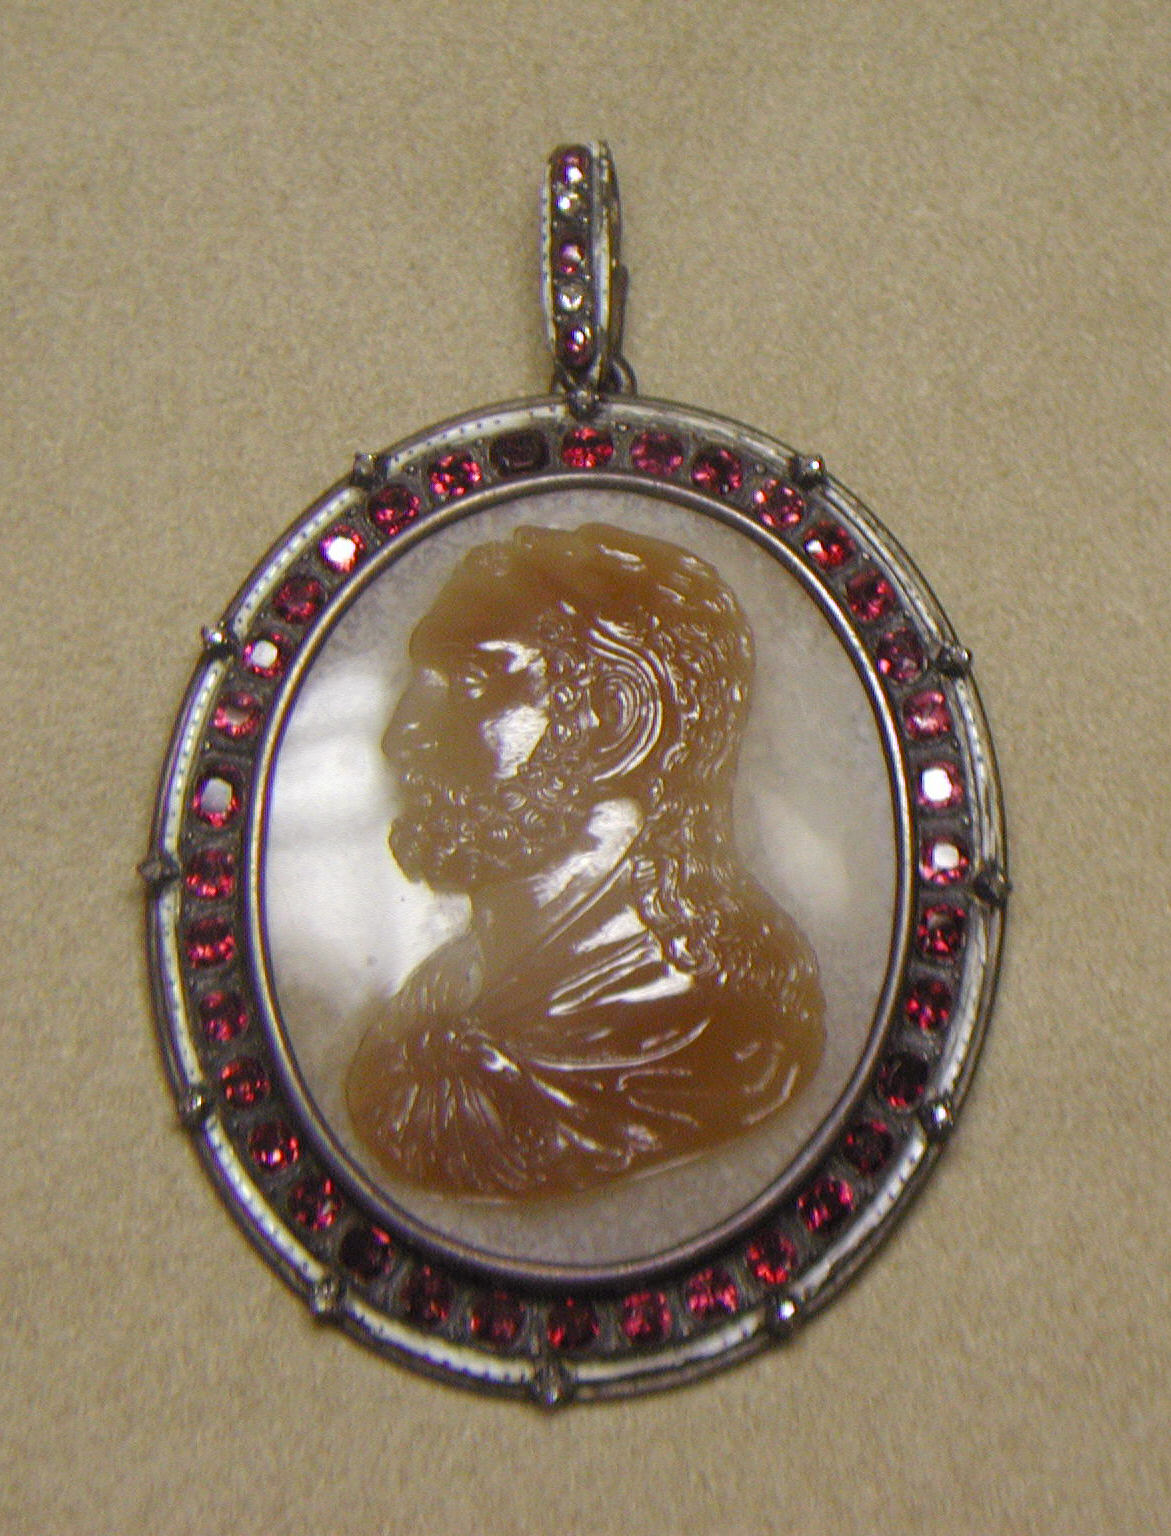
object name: cameo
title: Bust of Hercules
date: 1567-1633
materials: diamond, enamel, gold, gemstone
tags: profiles,hercules